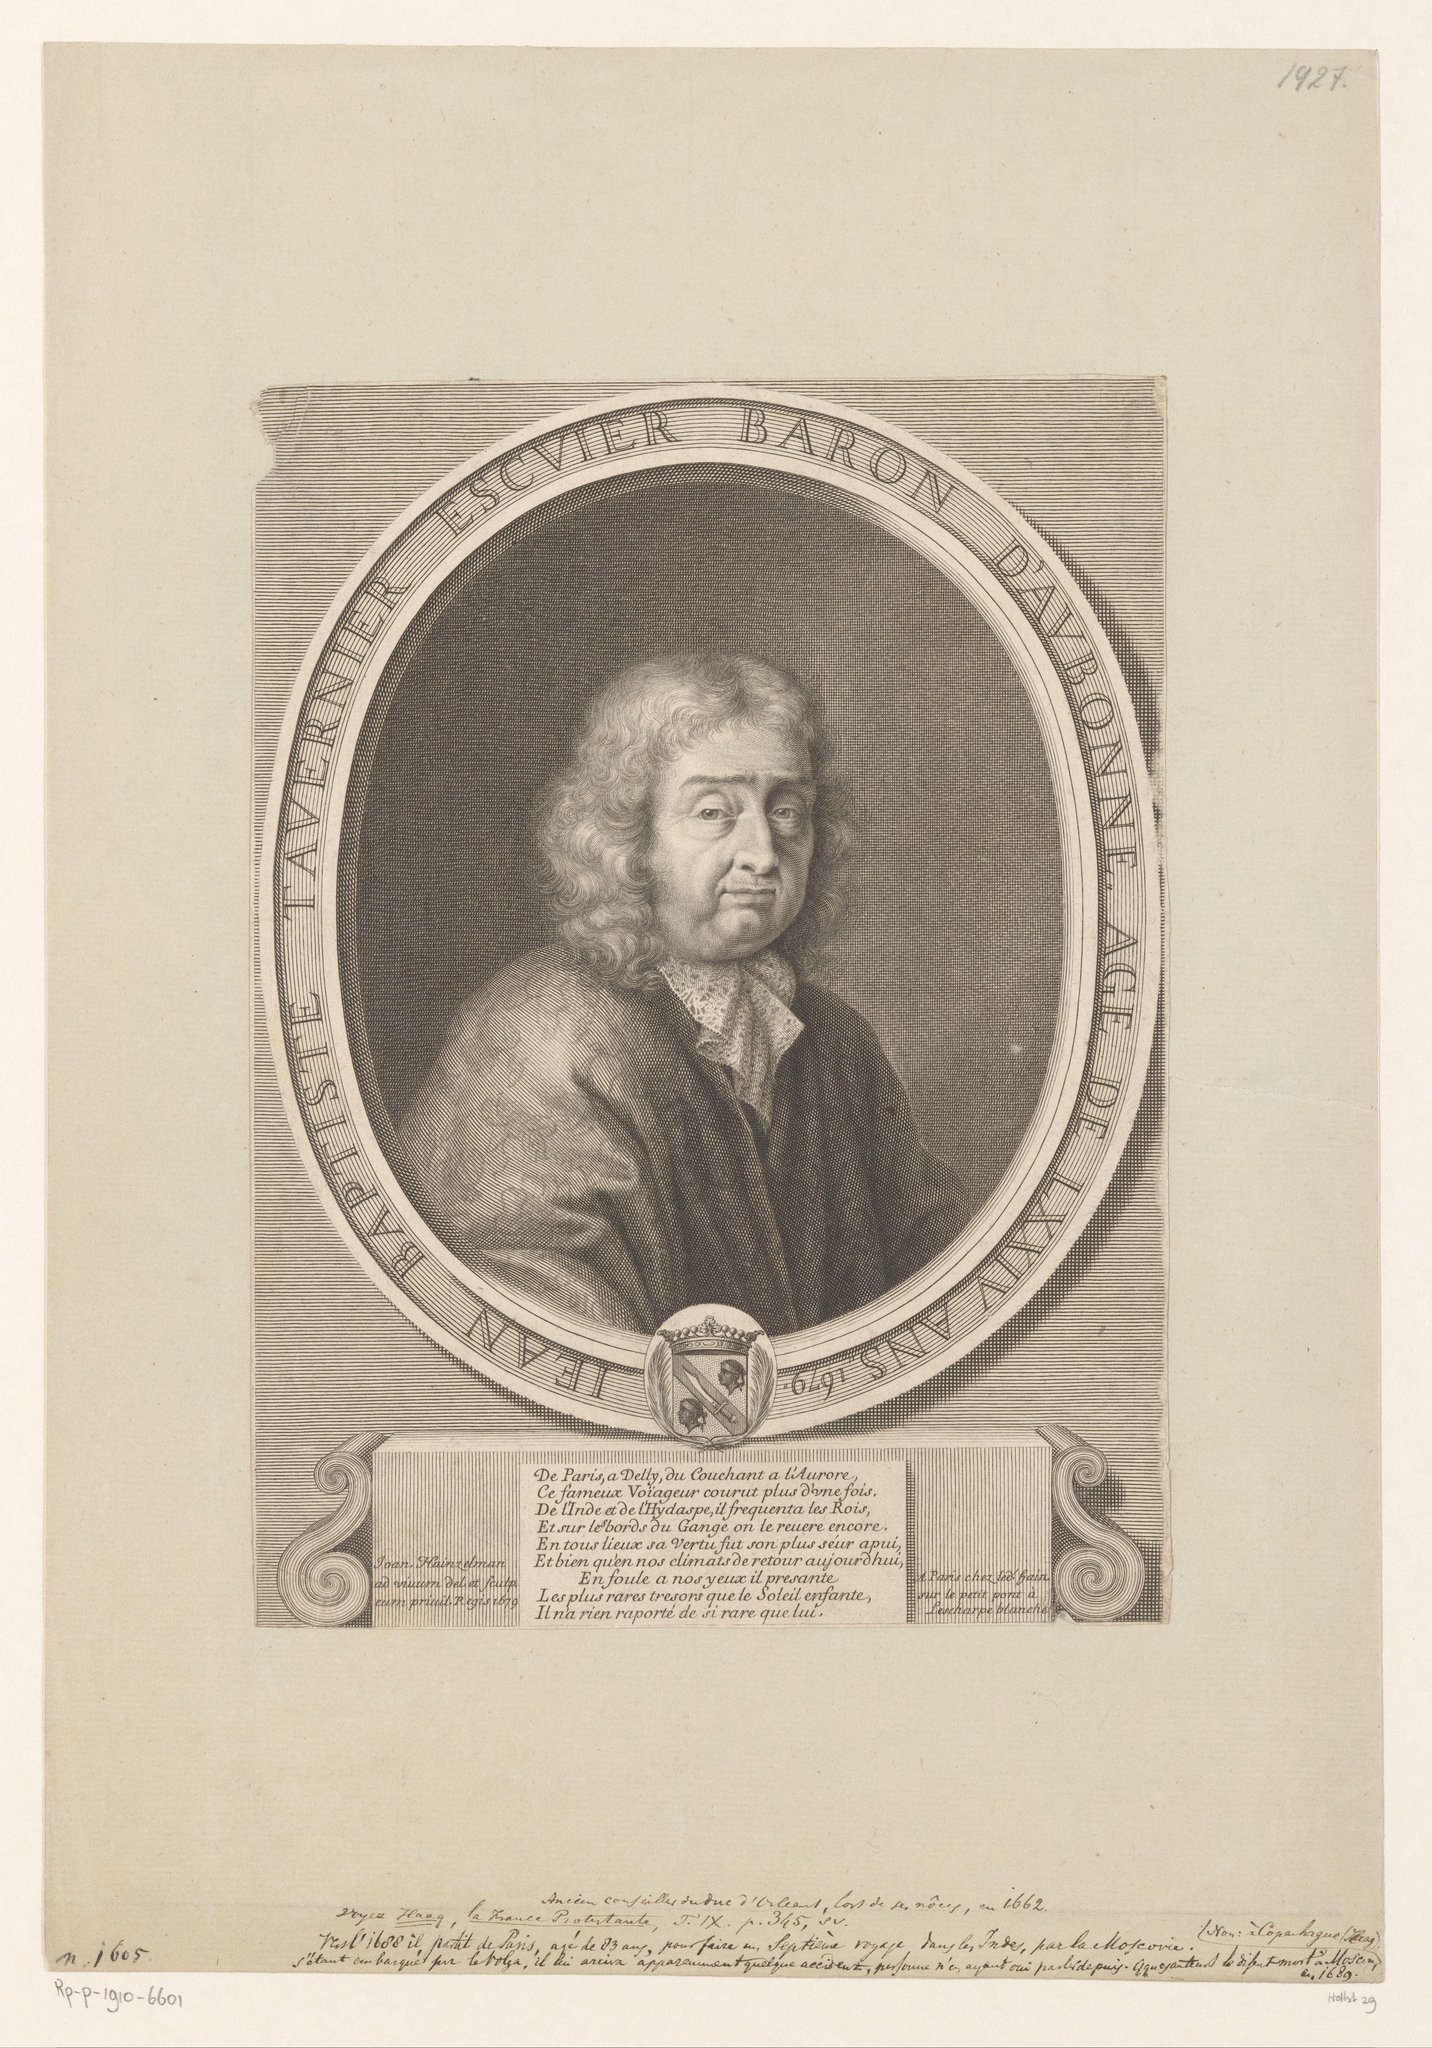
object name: print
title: Portret van Jean-Baptiste Tavernier op 74-jarige leeftijd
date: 1679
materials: paper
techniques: engraving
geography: paris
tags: paris, traveler, historical persons, armorial bearing, heraldry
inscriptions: collector's mark: Lugt 2228